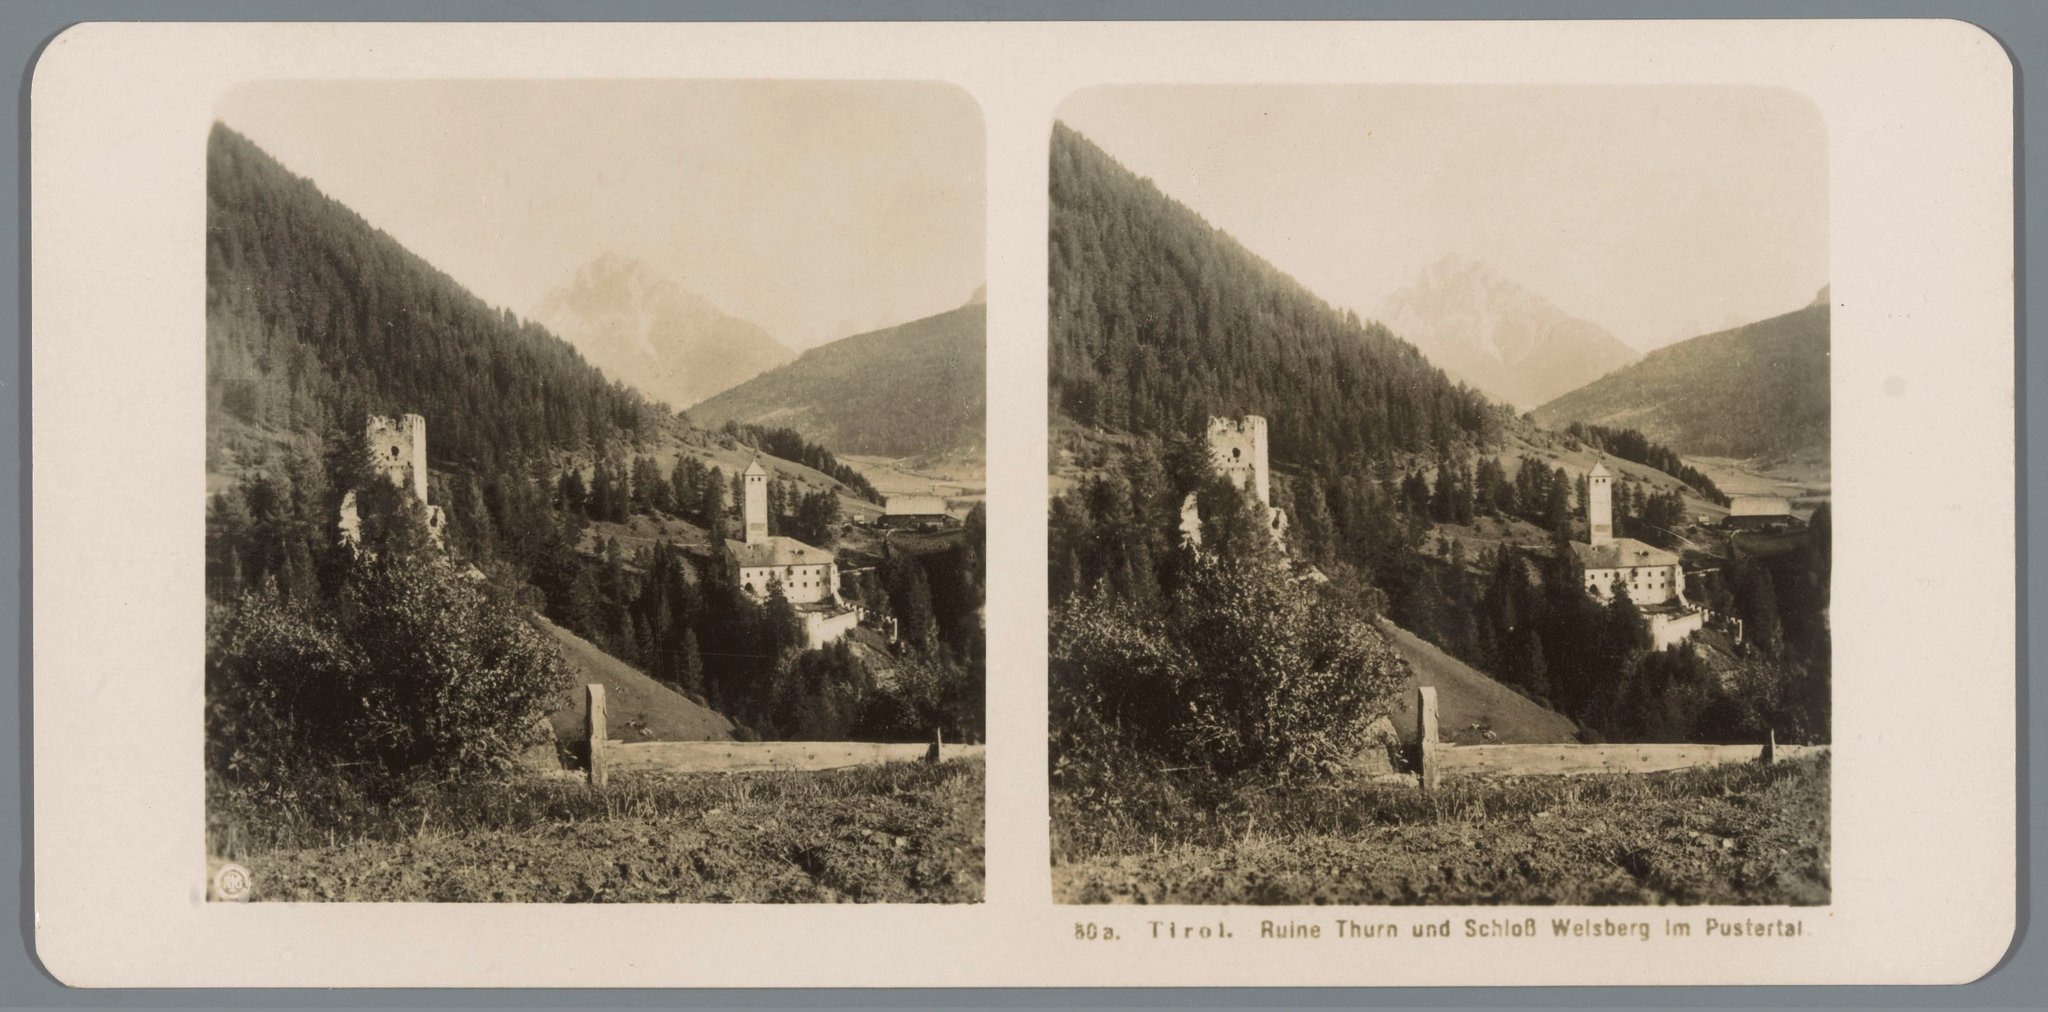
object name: stereograph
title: Gezicht op Slot Welsperg te Tirol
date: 1900-1910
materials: cardboard, photographic support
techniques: gelatin silver print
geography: tirol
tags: city-view in general; 'veduta', mountains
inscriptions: inscription: ‘NPG’, number: ‘80 a.’